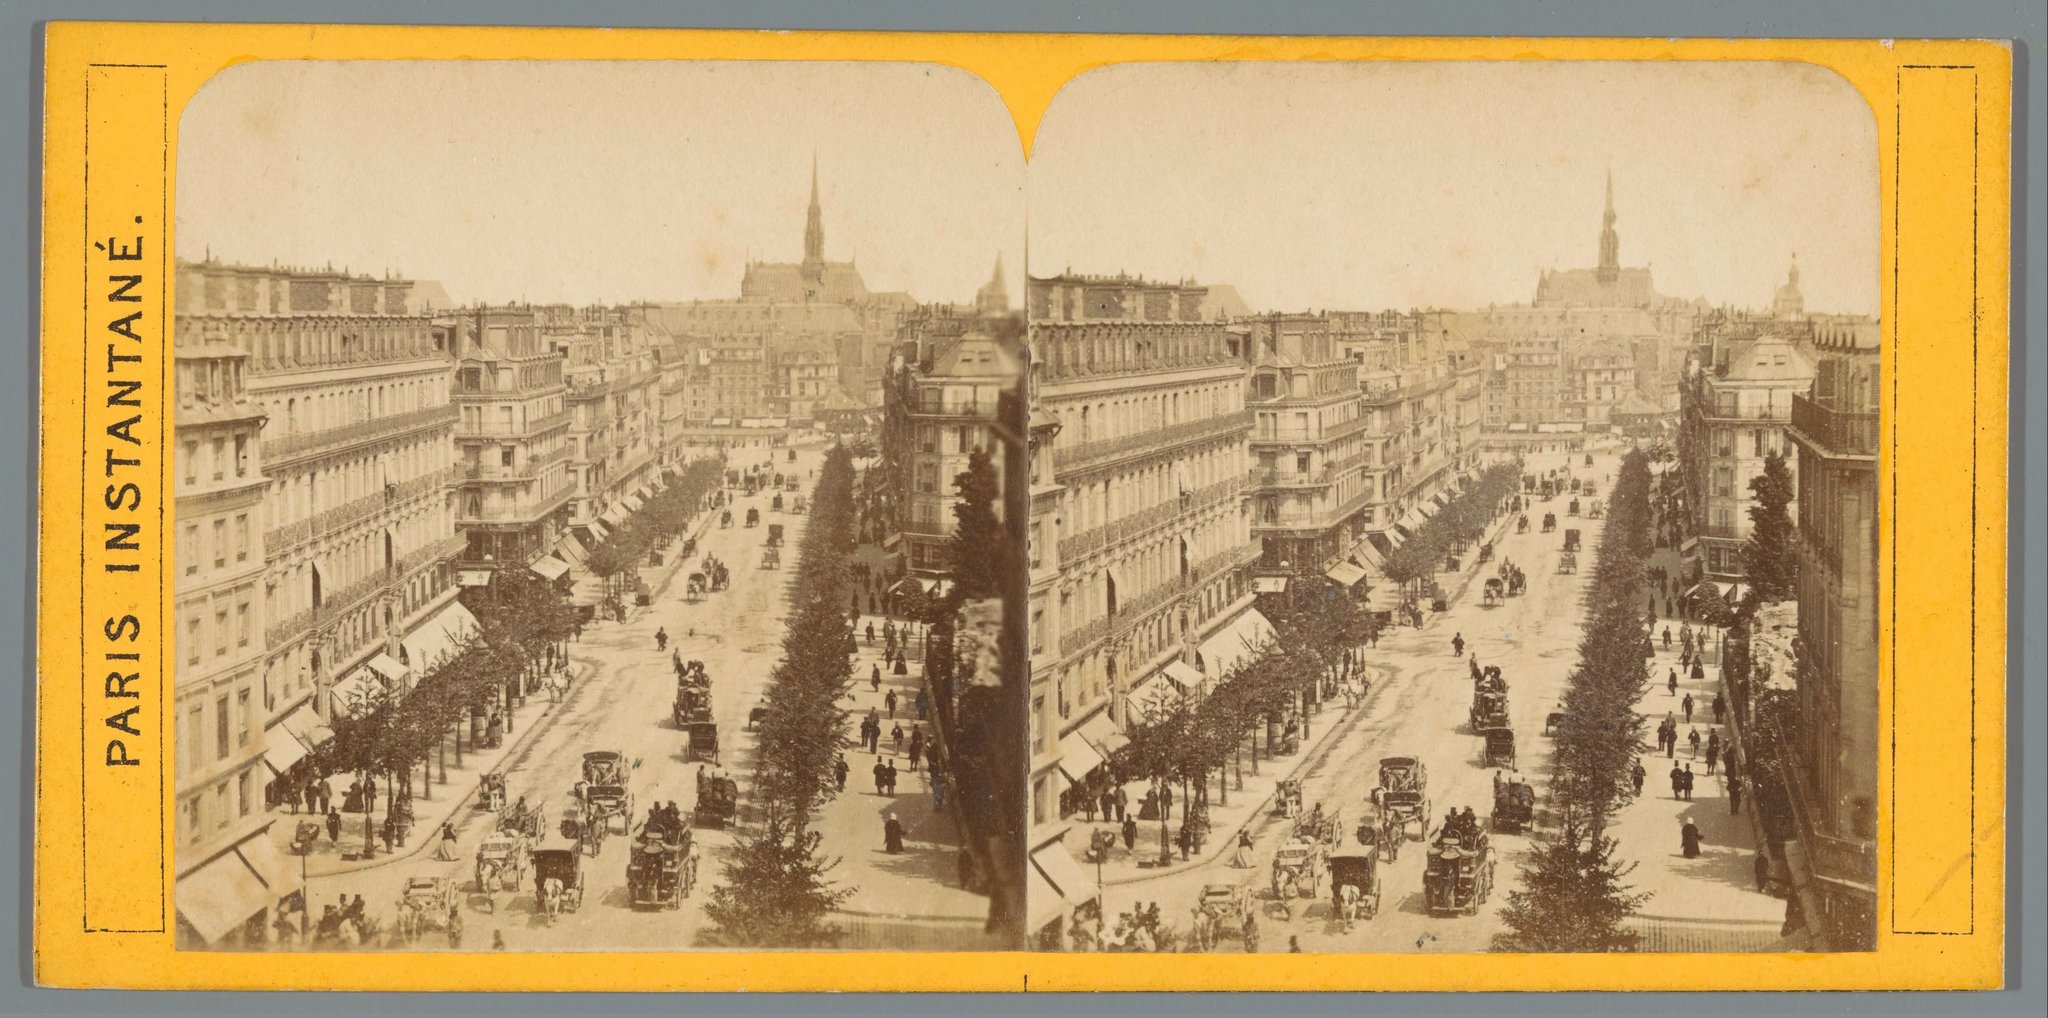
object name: stereograph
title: Paris Instantané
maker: adolphe block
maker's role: publisher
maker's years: 1829-1918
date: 1850-1880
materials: cardboard, photographic support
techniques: albumen print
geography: paris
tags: animal traction, animal-drawn vehicle (carriage etc.), church (exterior), street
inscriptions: number: ‘No. 11146 dt/eo’, number: ‘No. 247’